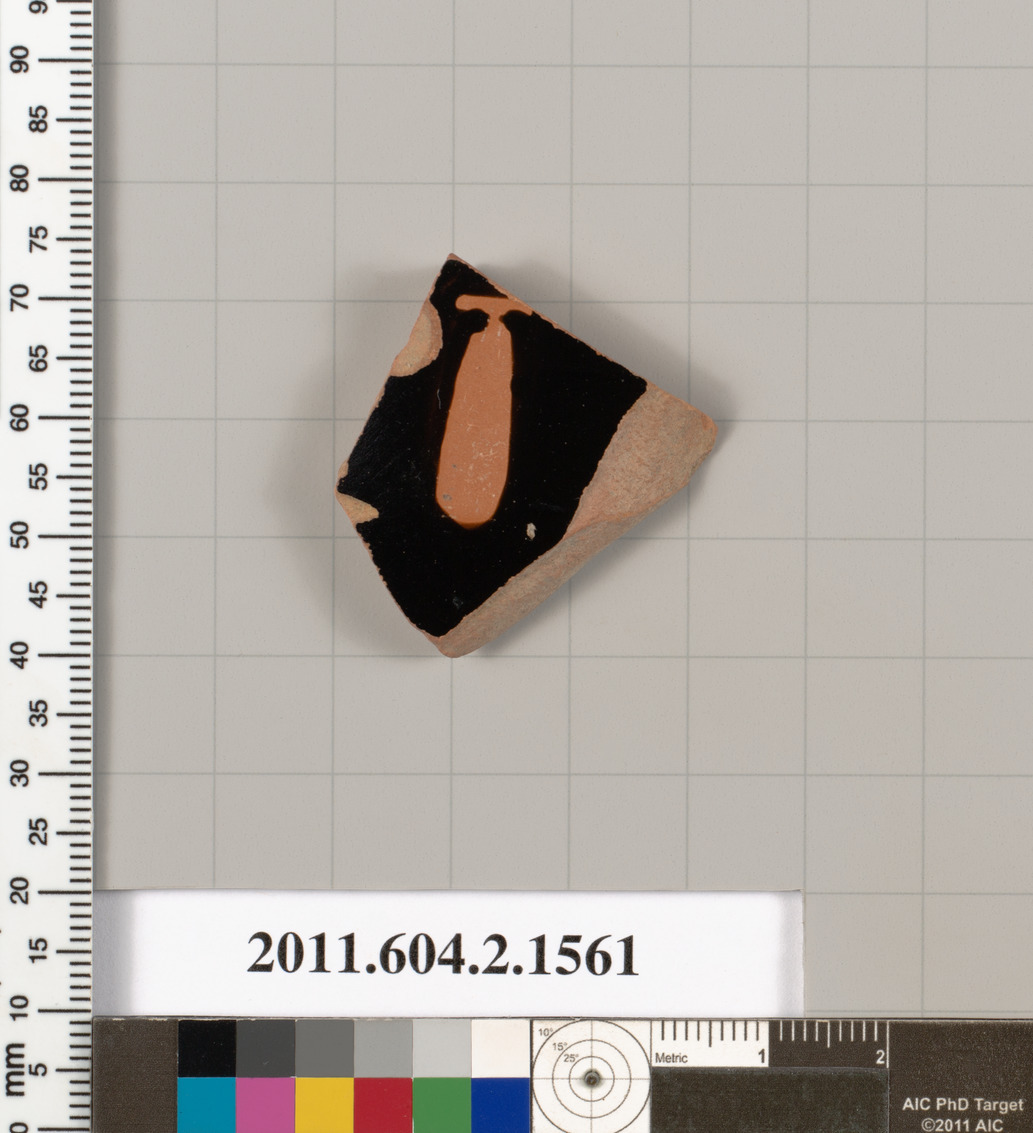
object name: skyphos fragment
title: Terracotta fragment of a skyphos (deep drinking cup)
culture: greek, attic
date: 475-451 BCE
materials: terracotta